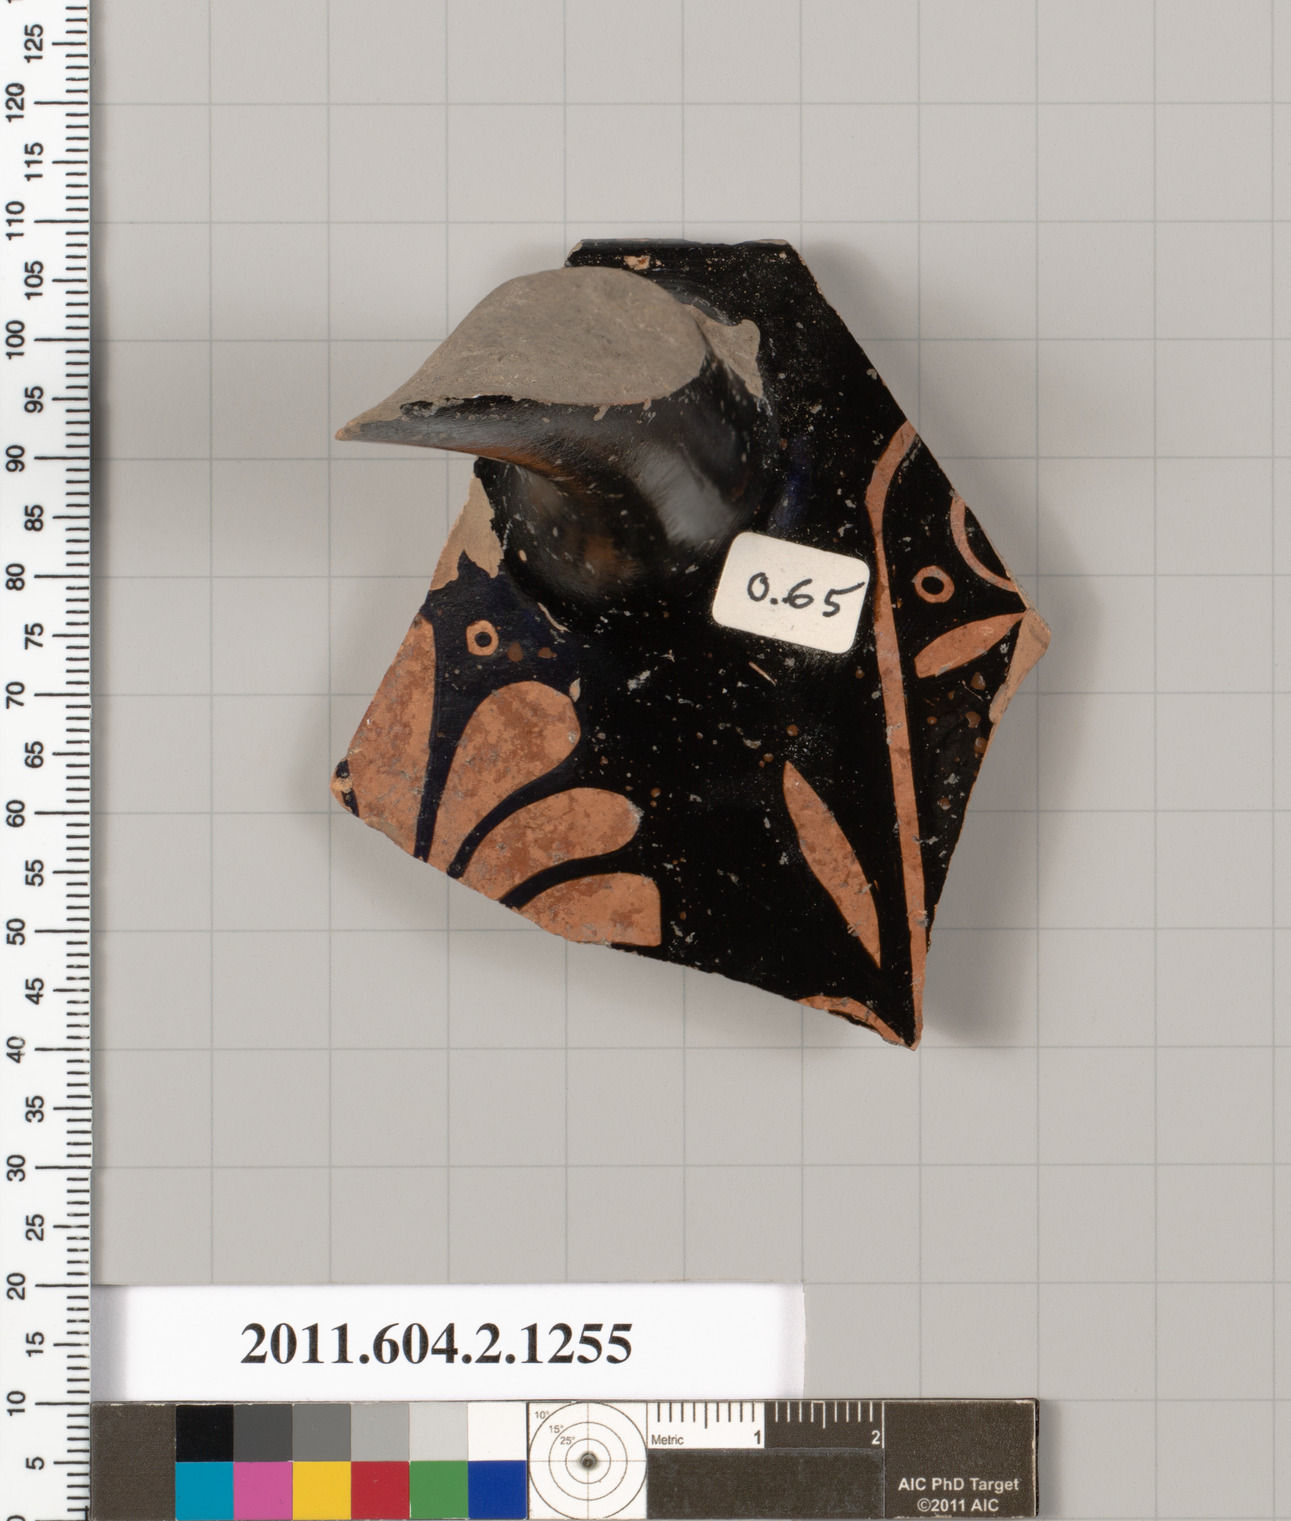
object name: skyphos fragment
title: Terracotta fragment of a skyphos (deep drinking cup)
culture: greek, attic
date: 475-451 BCE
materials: terracotta